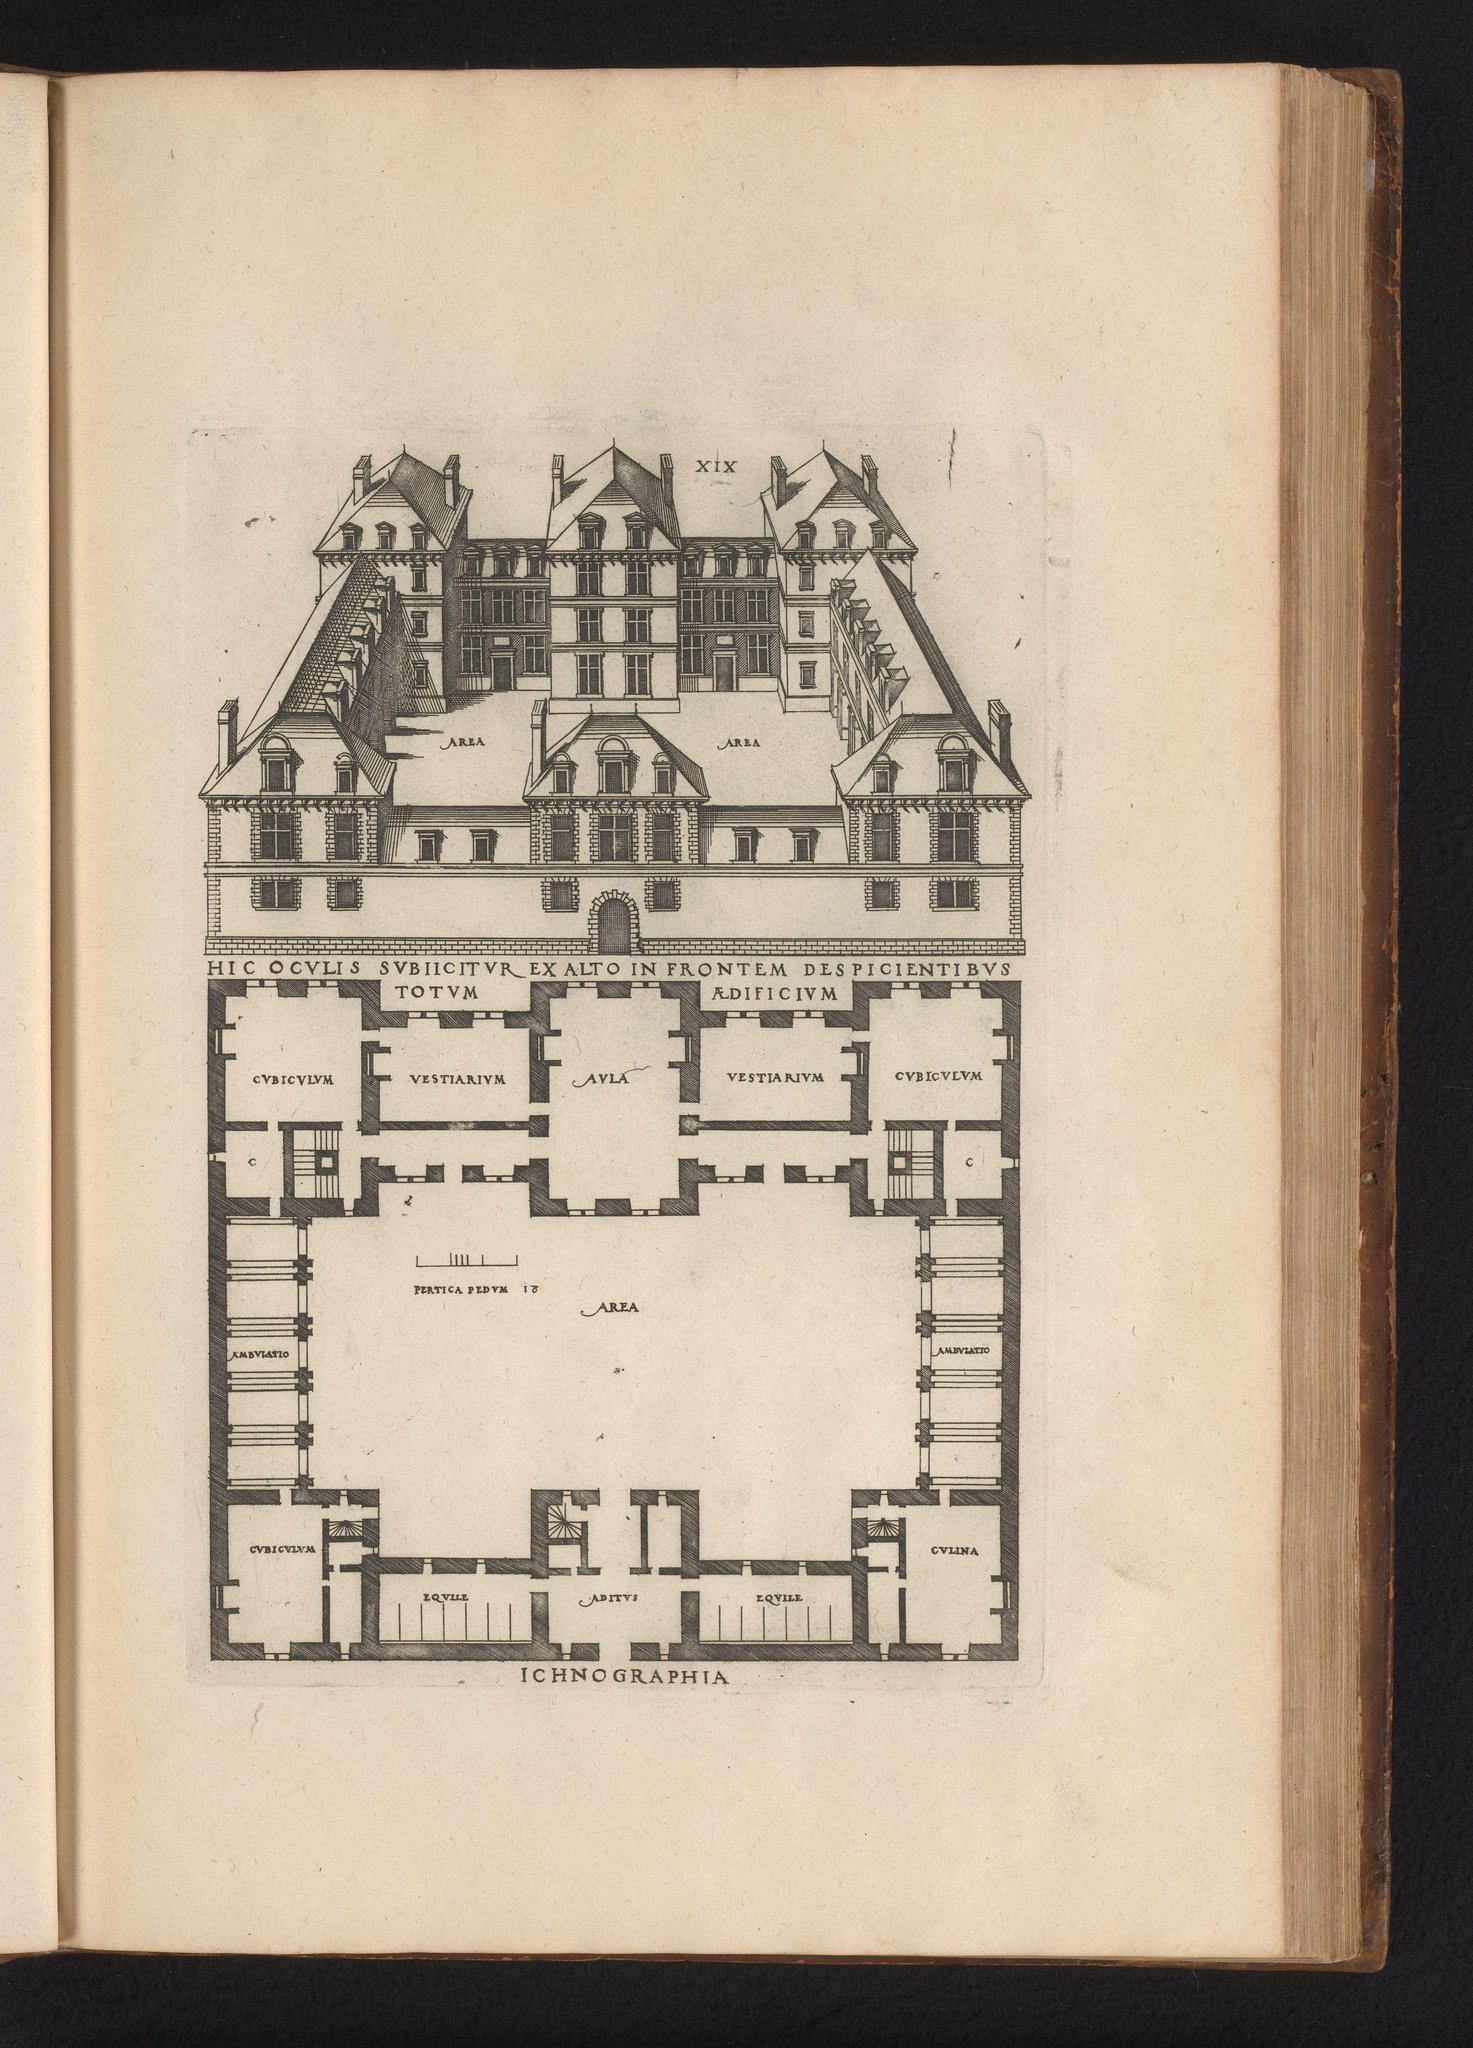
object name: ornament print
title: Vogelvluchtperspectief en plattegrond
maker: jacques androuet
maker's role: draughtsman, print maker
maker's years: 1515-1584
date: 1559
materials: paper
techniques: etching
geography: paris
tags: façade (of house or building), plan ~ architecture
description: Vogelvluchtperspectief en plattegrond van architectuur. Genummerd: XIX. Onderdeel van 'De architectura Iacobi Androuetii du Cerceau' (1559): 69 etsen met 171 voorstellingen van architectuur en ornamentiek.